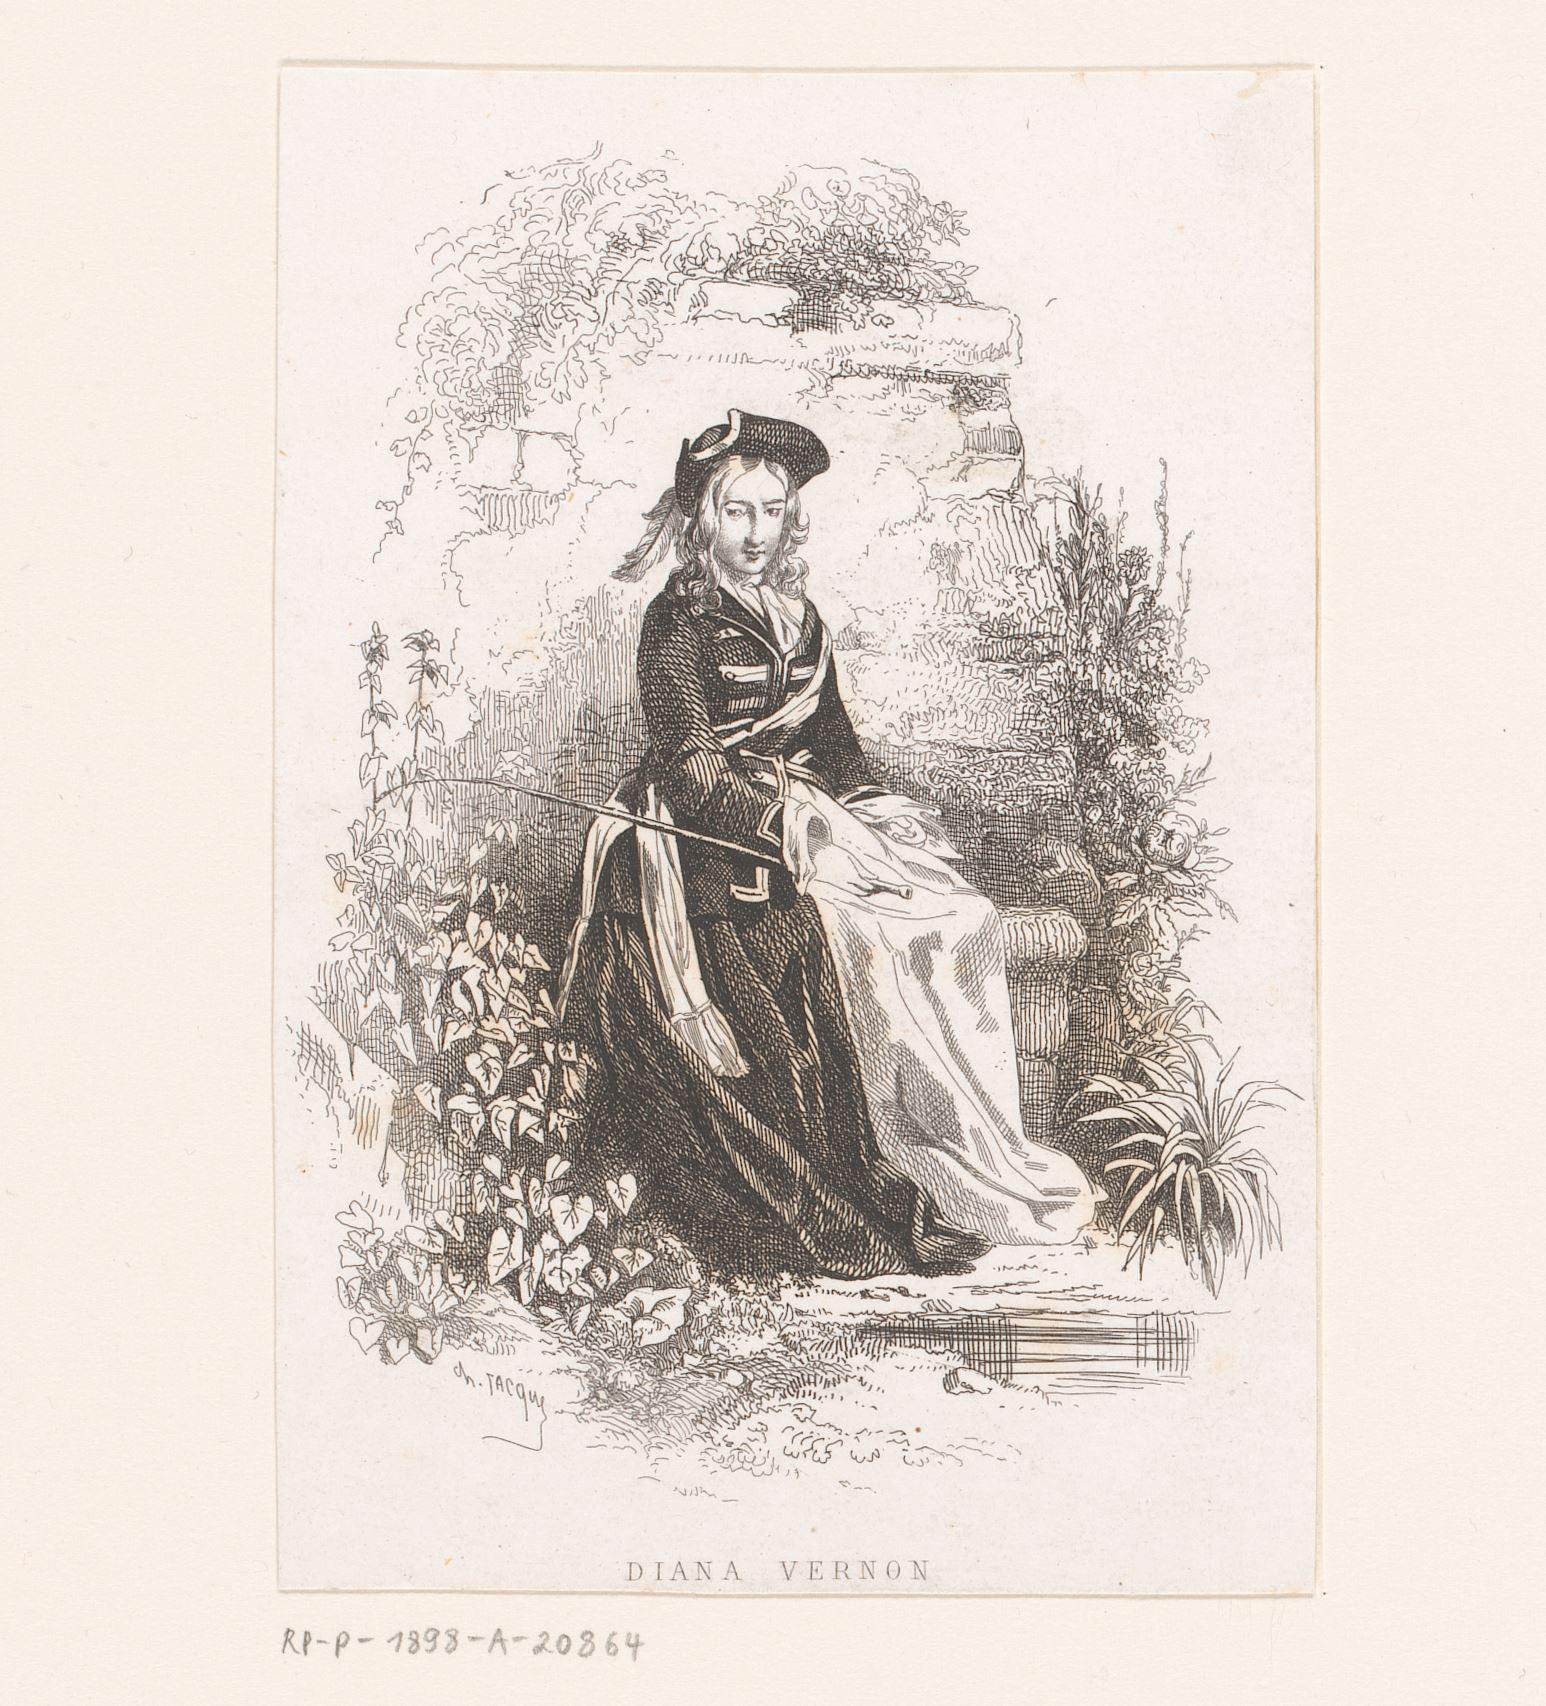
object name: print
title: Diana Vernon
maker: charles emile jacque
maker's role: draughtsman, painter, print maker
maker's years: 1813-1894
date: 1844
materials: paper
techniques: etching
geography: paris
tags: adult woman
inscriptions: collector's mark: Lugt 964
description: Prent uit: Oeuvres de Walter Scott. Parijs: Firmin-Didot, 1844.